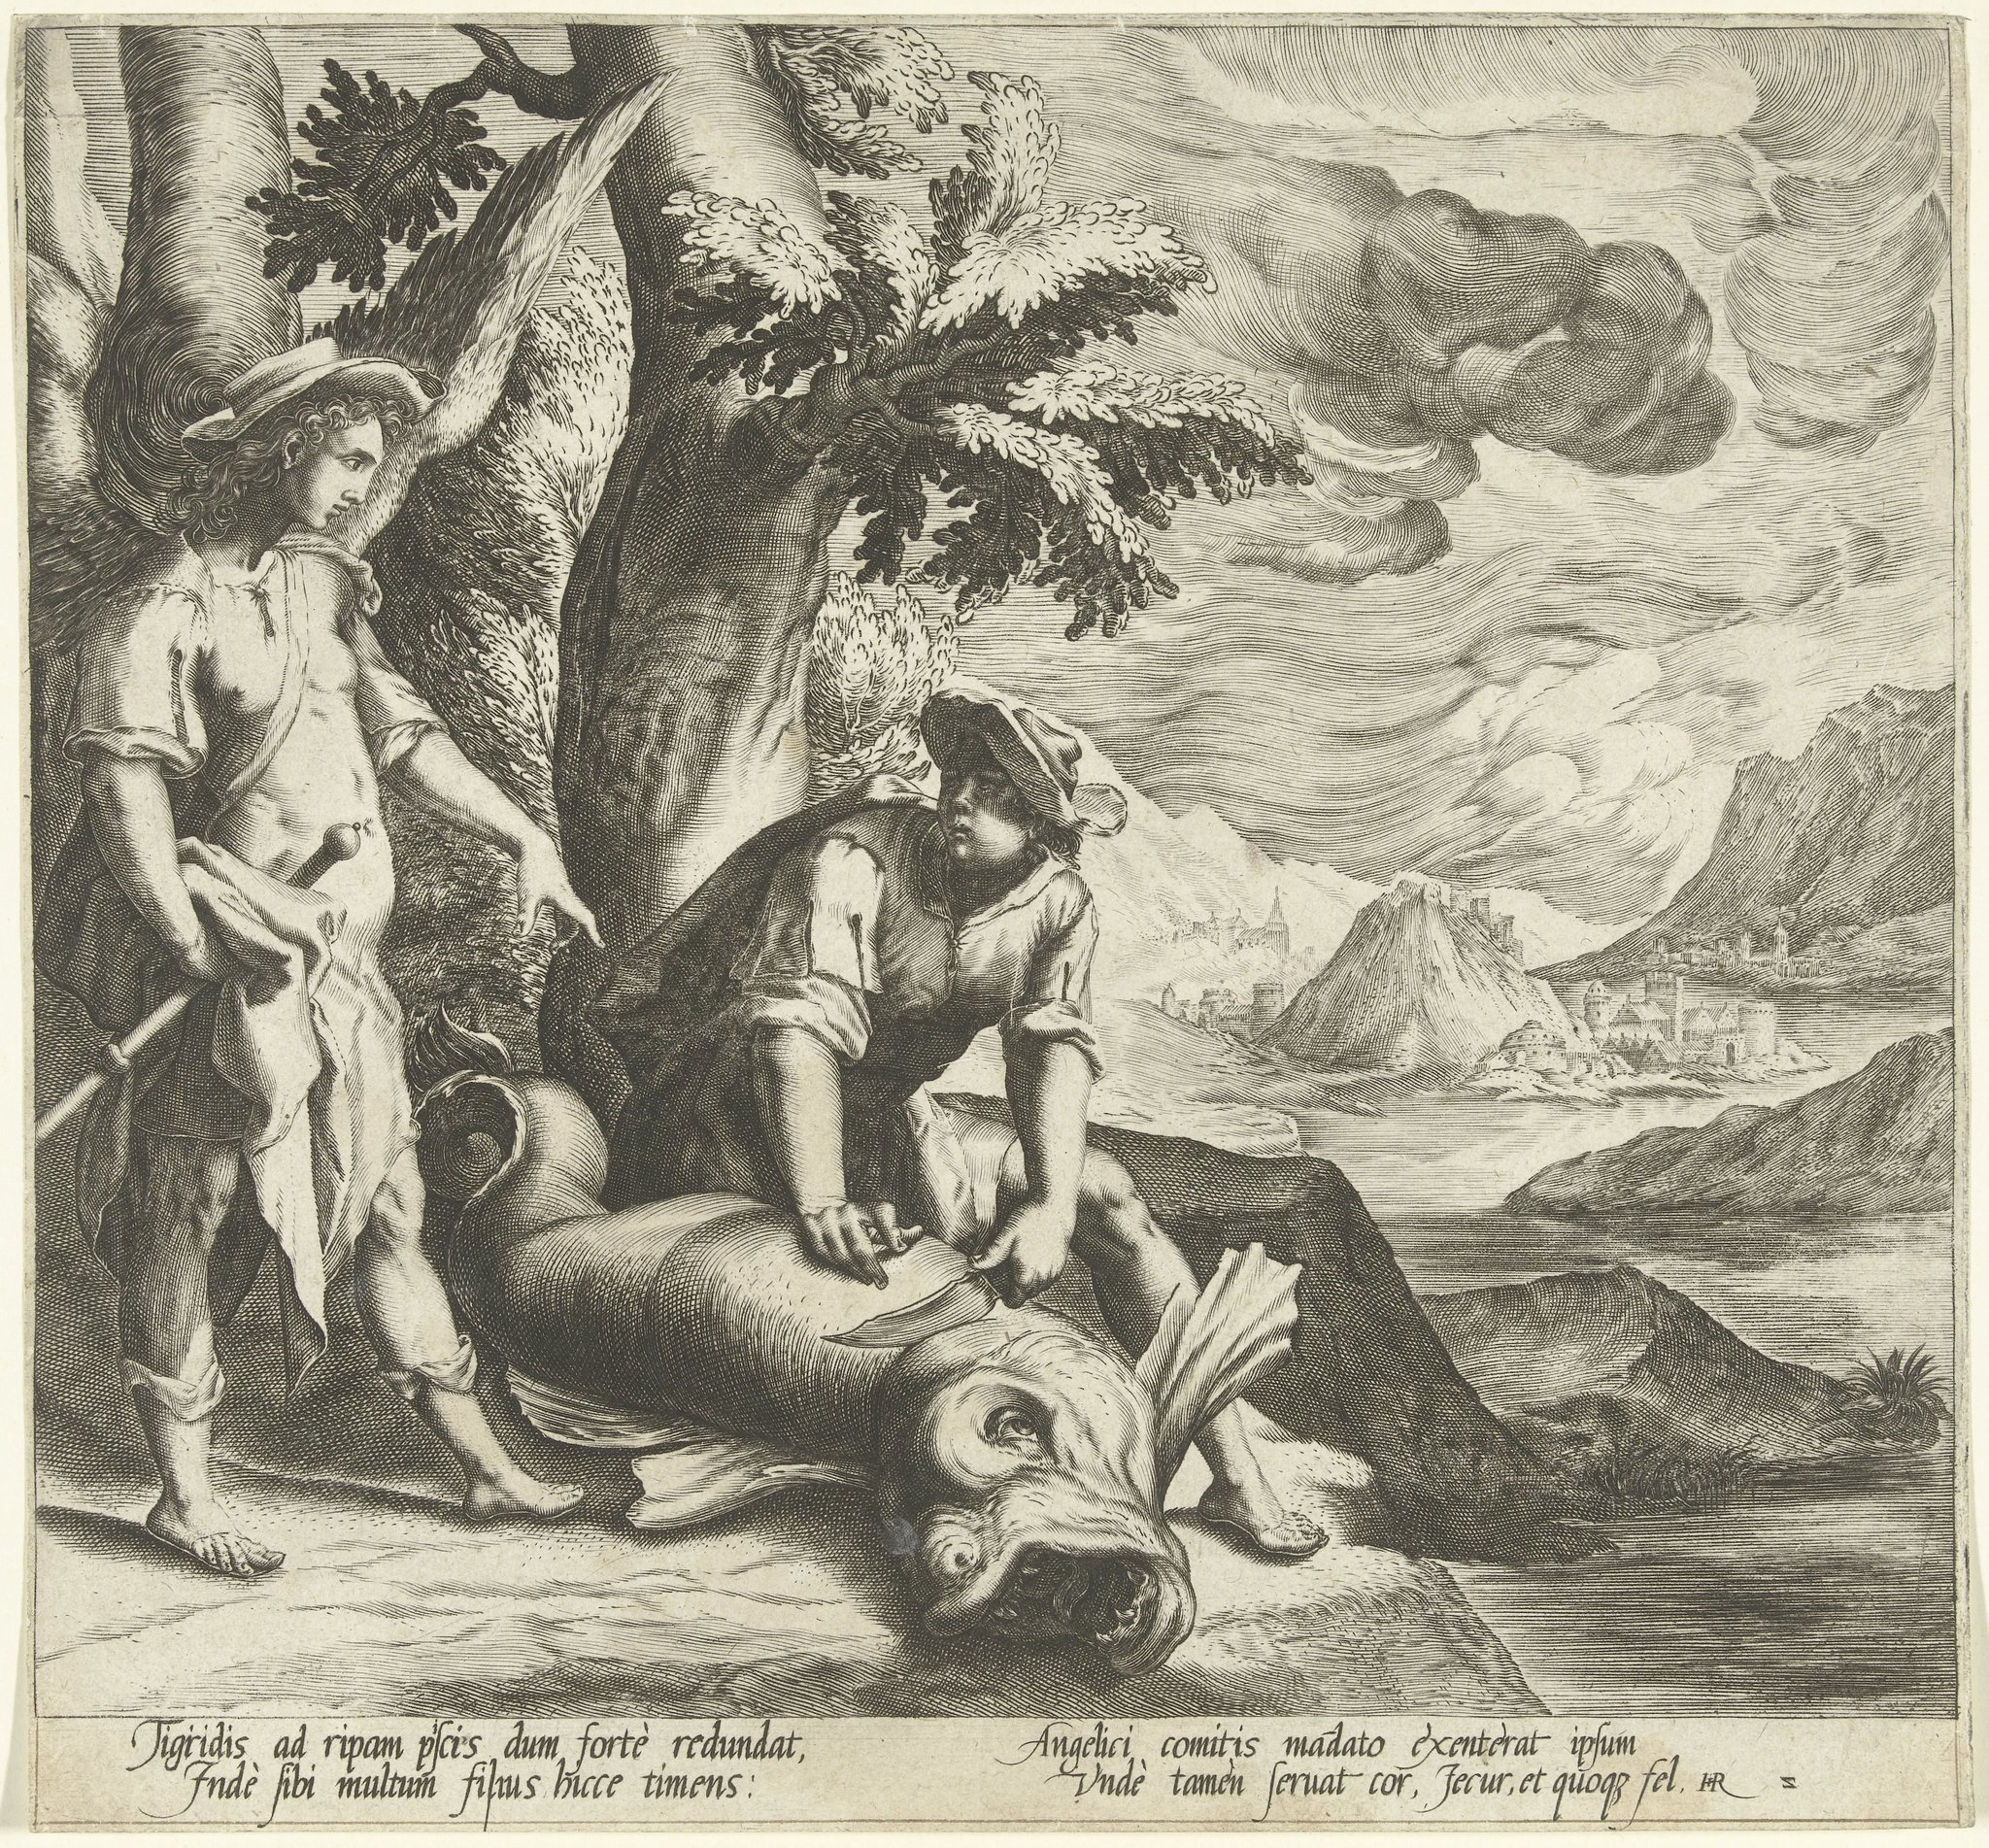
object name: print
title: Tobias vangt de grote vis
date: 1590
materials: paper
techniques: engraving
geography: netherlands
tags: the angel raphael tells tobias to cut the fish to pieces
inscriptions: collector's mark: Lugt 2760, collector's mark: Lugt 2228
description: Tobias heeft de grote vis gevangen. De engel Rafael vraagt hem om de vis in stukken te snijden en de ingewanden te bewaren. Deel uit een serie met vijf prenten over het leven van Tobias.